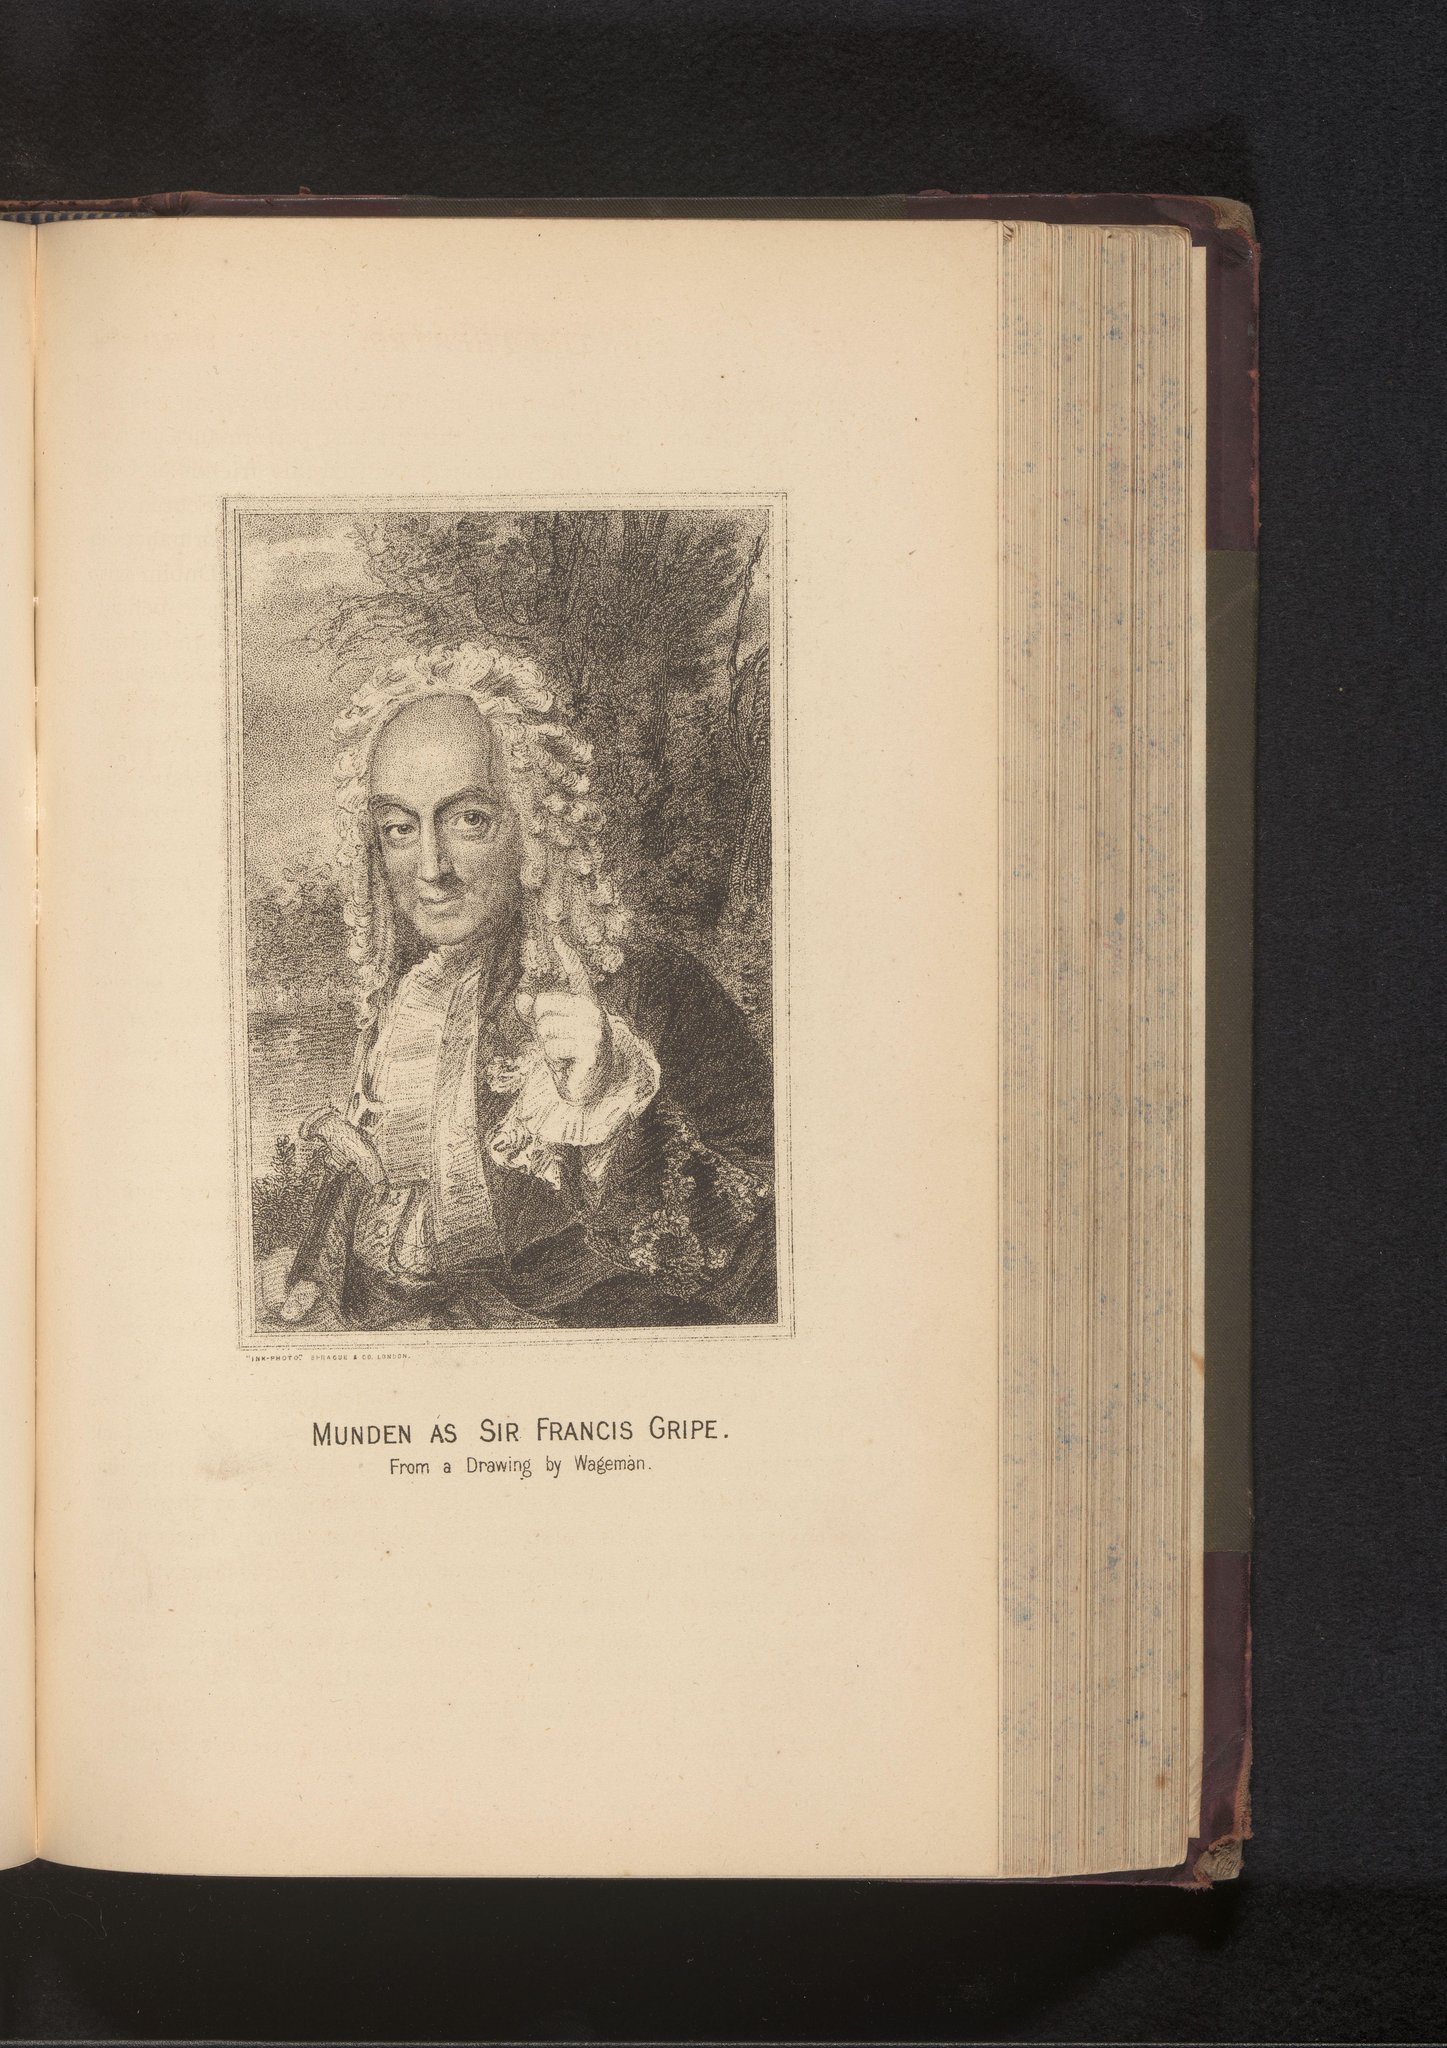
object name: reproduction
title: Reproductie van een getekend portret van Joseph Shepherd Munden als Sir Francis Gripe door Wageman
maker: thomas charles wageman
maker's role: print maker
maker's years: 1787-1863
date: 1879-1884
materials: paper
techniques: planographic printing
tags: adult man, historical persons